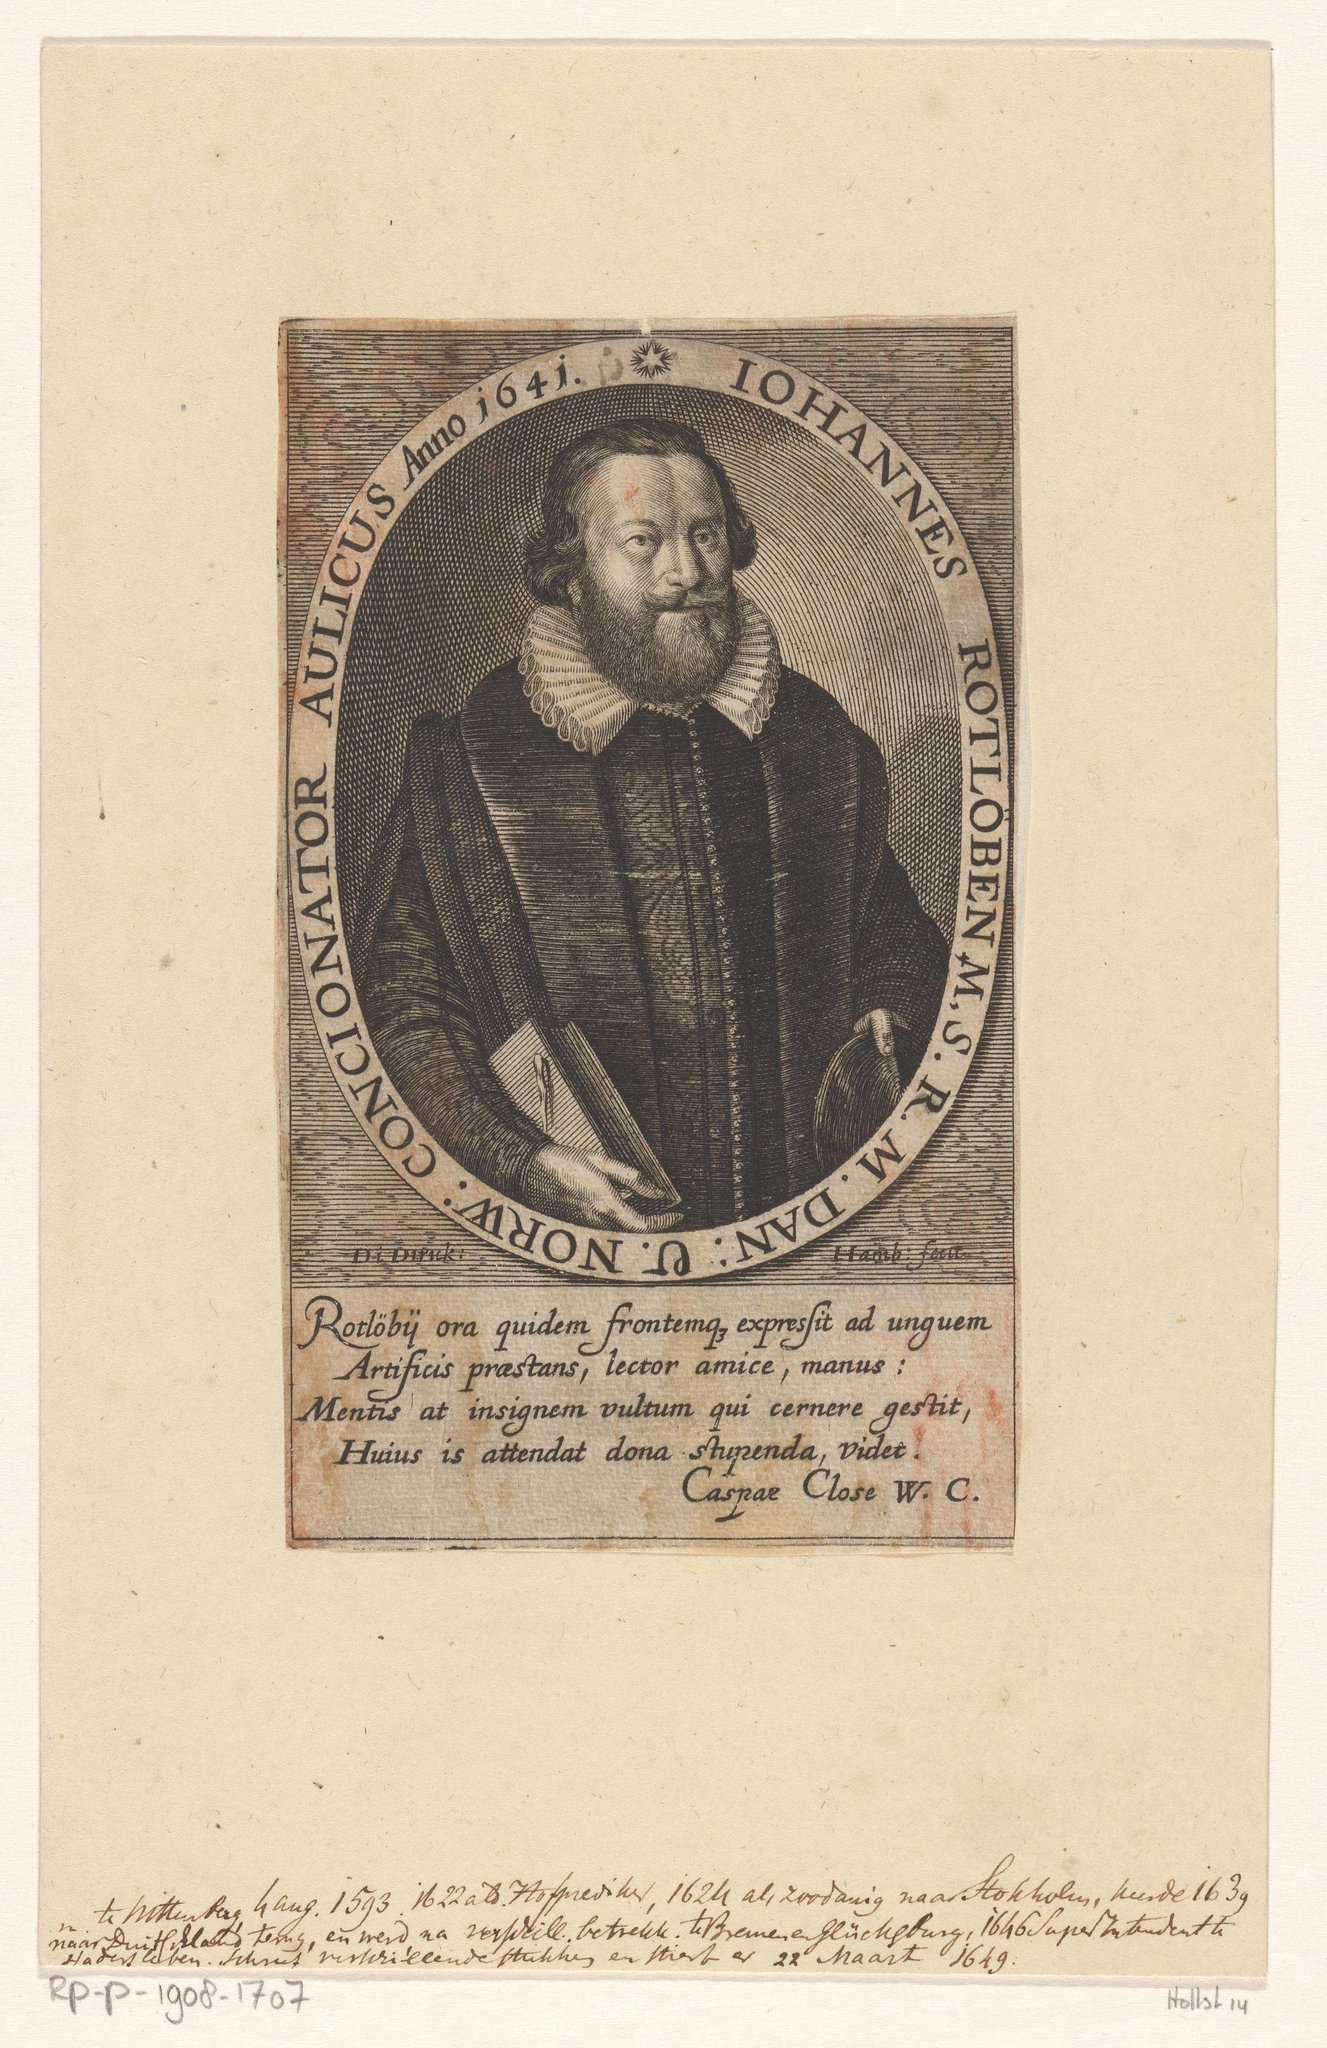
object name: print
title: Portret van Johannes Rotlöben op 48-jarige leeftijd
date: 1641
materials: paper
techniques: engraving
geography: hamburg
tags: historical persons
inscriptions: date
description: Met biografische gegevens rondom het portret en onderschrift in het Latijn.